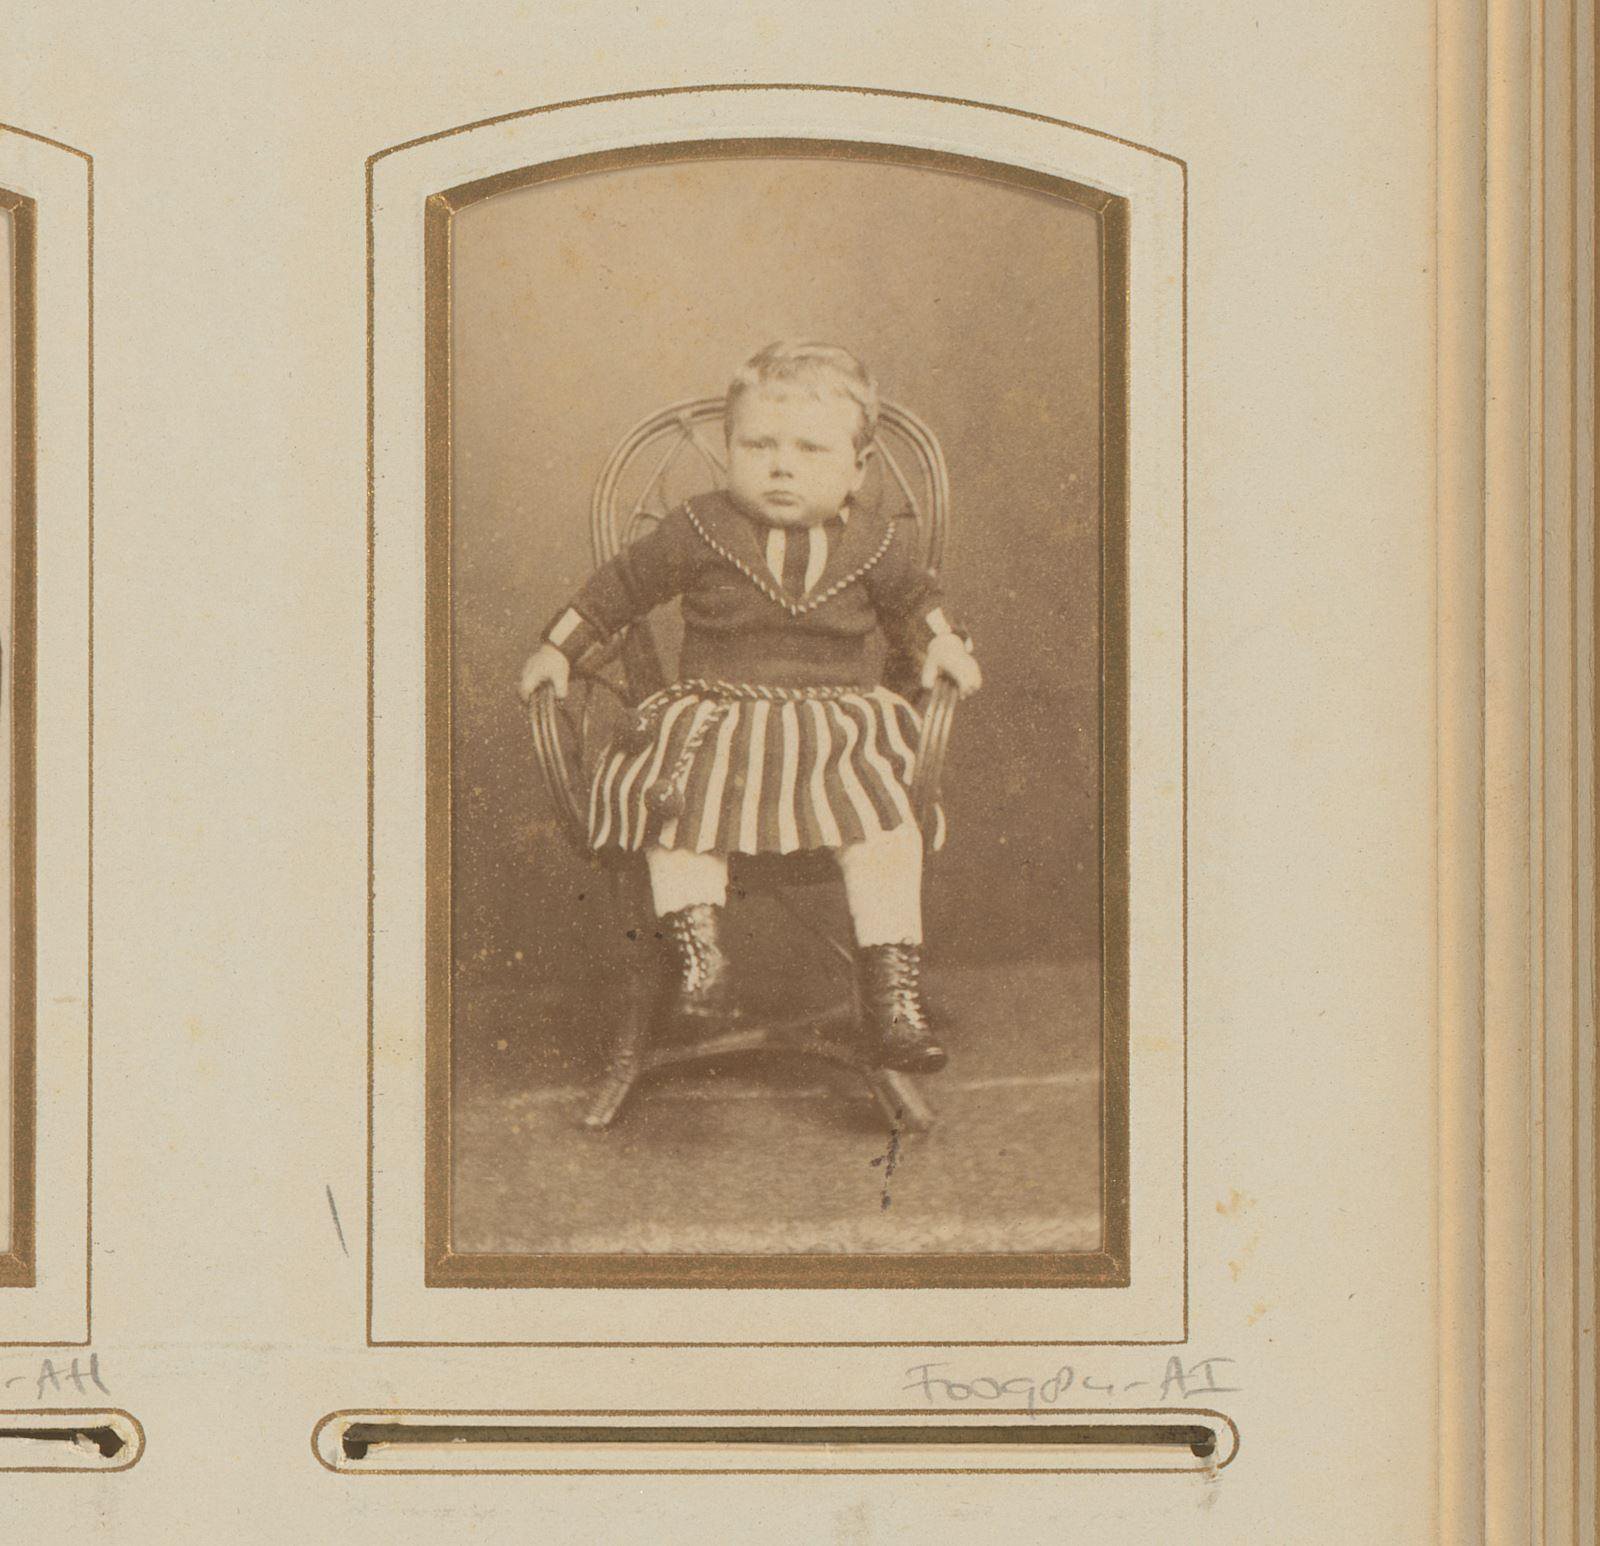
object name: carte de visite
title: Portret van een jongen, zittend in een rotanstoel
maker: albert daniel prummel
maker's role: fotograaf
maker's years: 1862-1940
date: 1872-1900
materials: cardboard, photographic support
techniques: albumen print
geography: veendam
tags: sitting figure, historical persons, toddler (male), chair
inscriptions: inscription: ‘Photograph/ en/ Kunstschilder./ A. D. Prummel/ Veendam./ Beneden Westerdiep./ De plaat blijft ter nabestelling bewaard.’